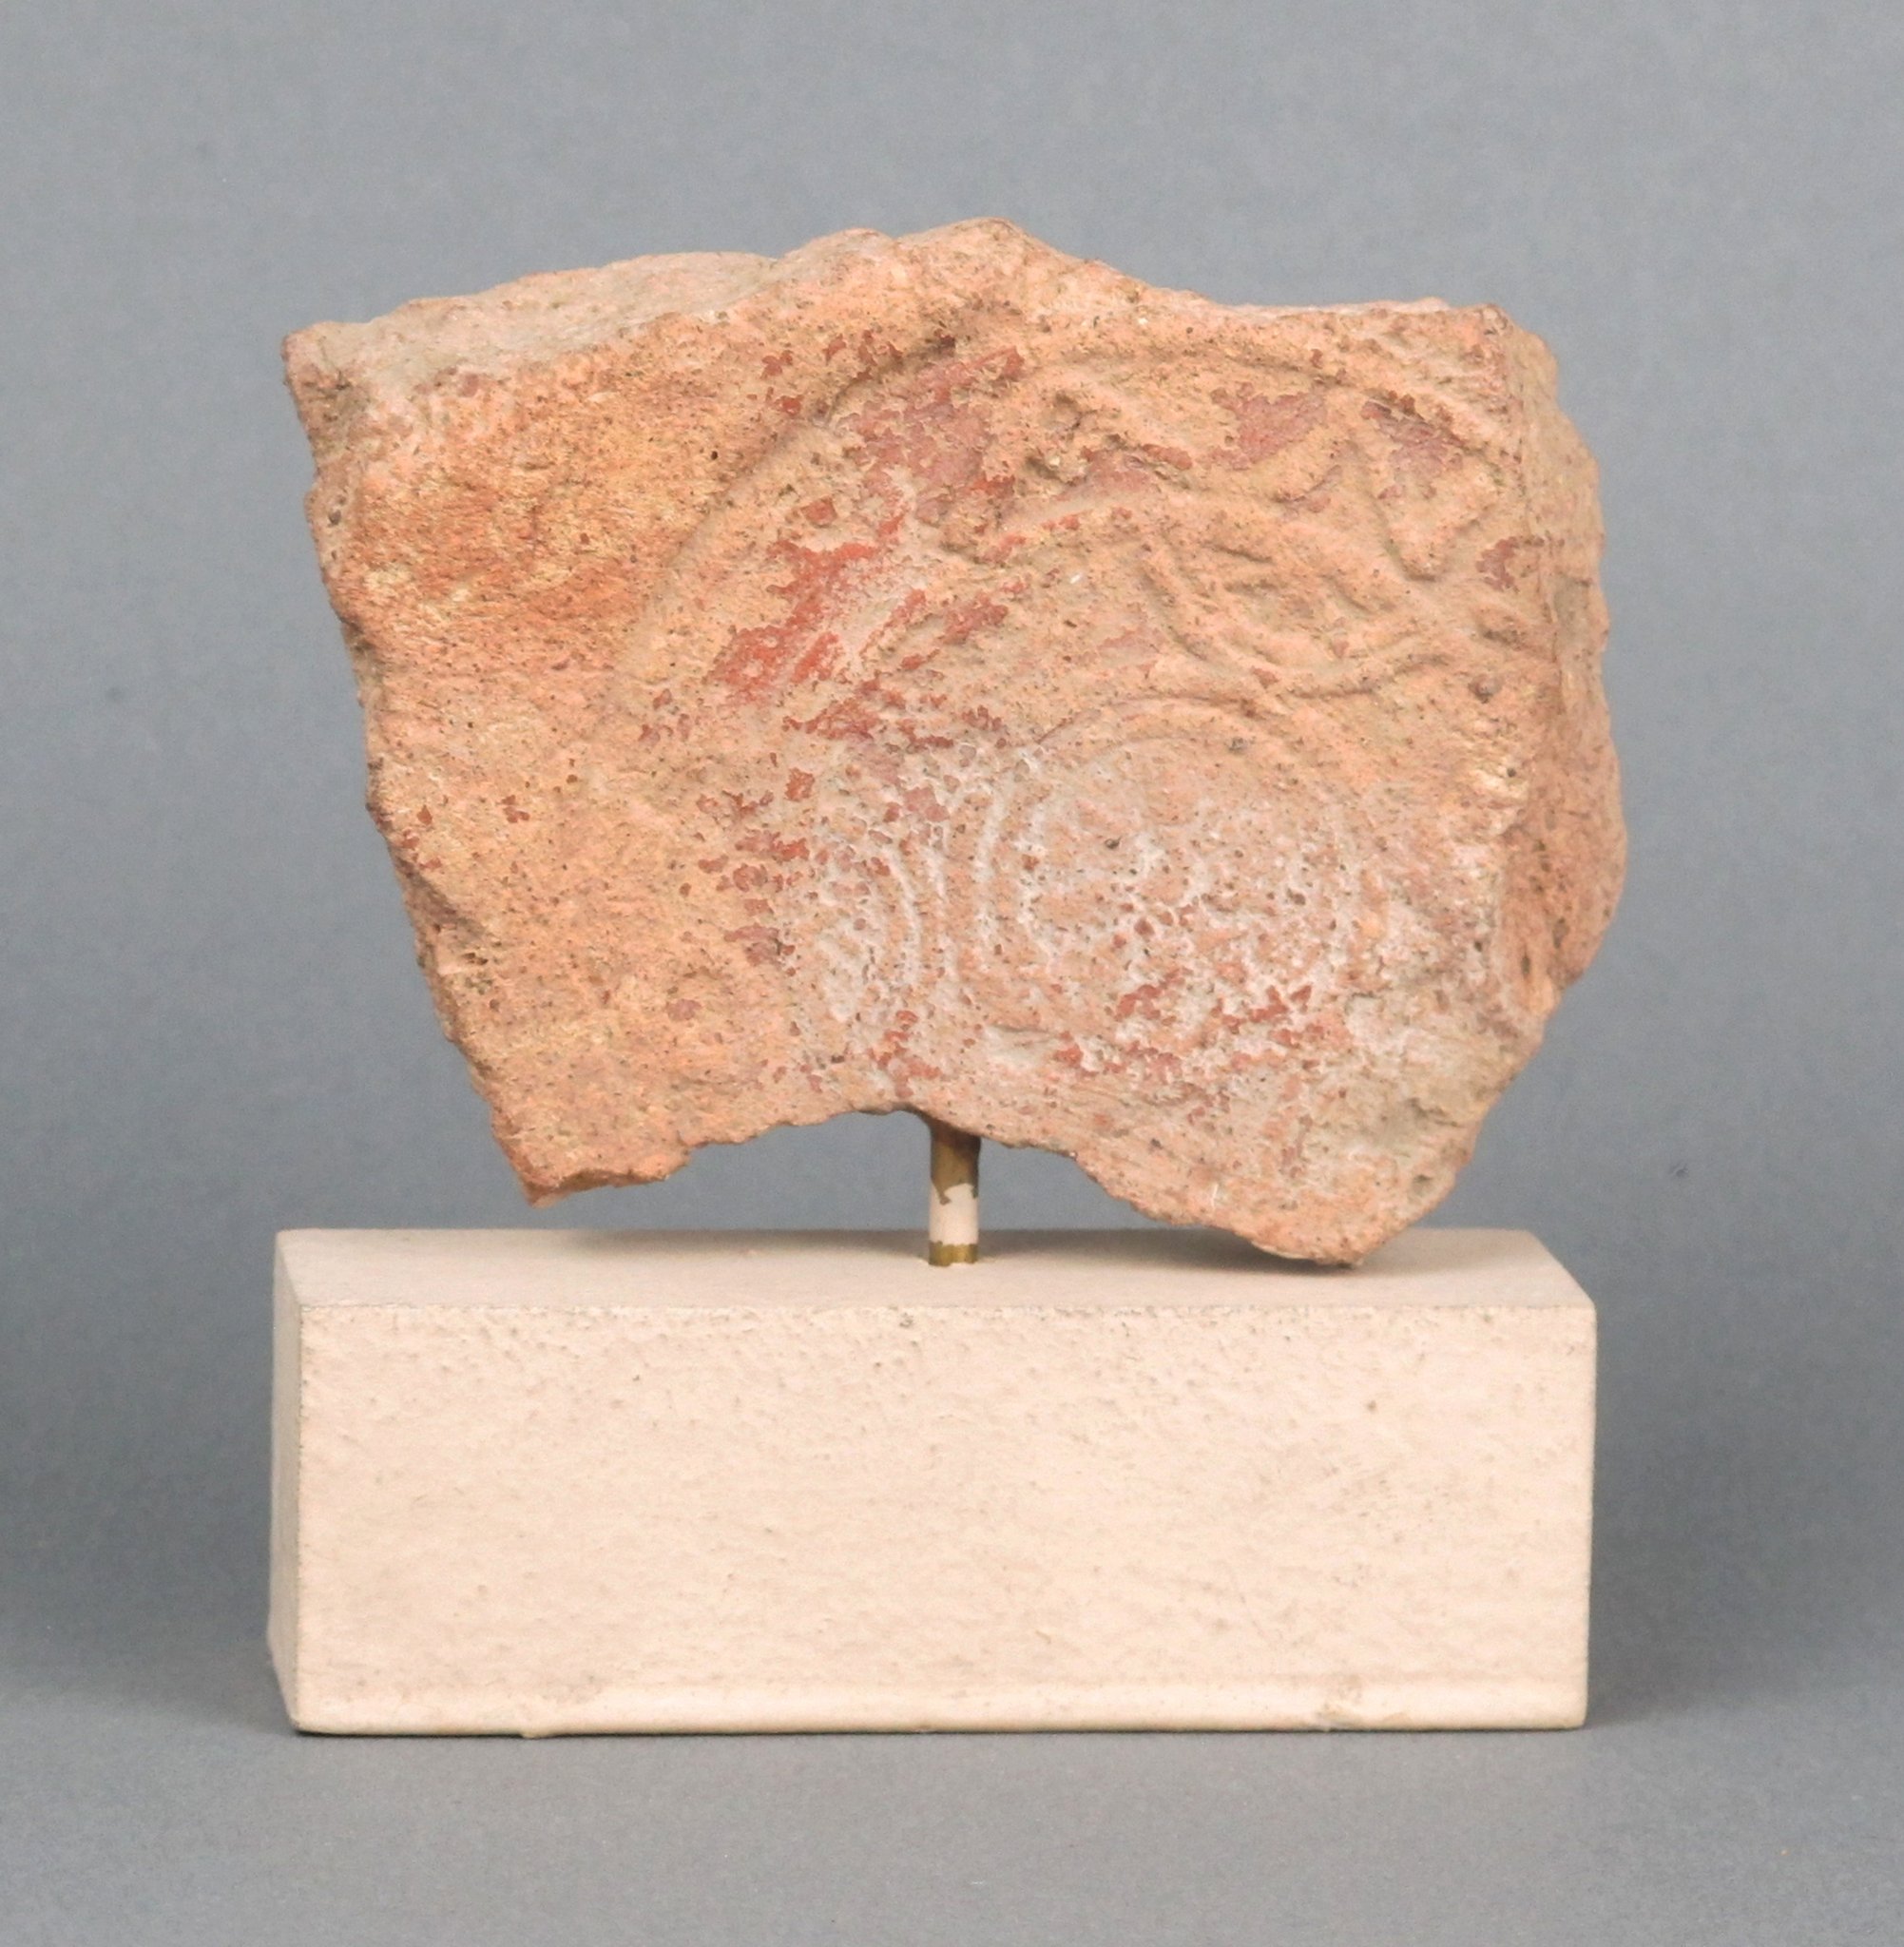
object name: vase, stamped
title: Terracotta stamped brick fragment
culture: cypriot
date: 3900 BCE-100 CE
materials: stone